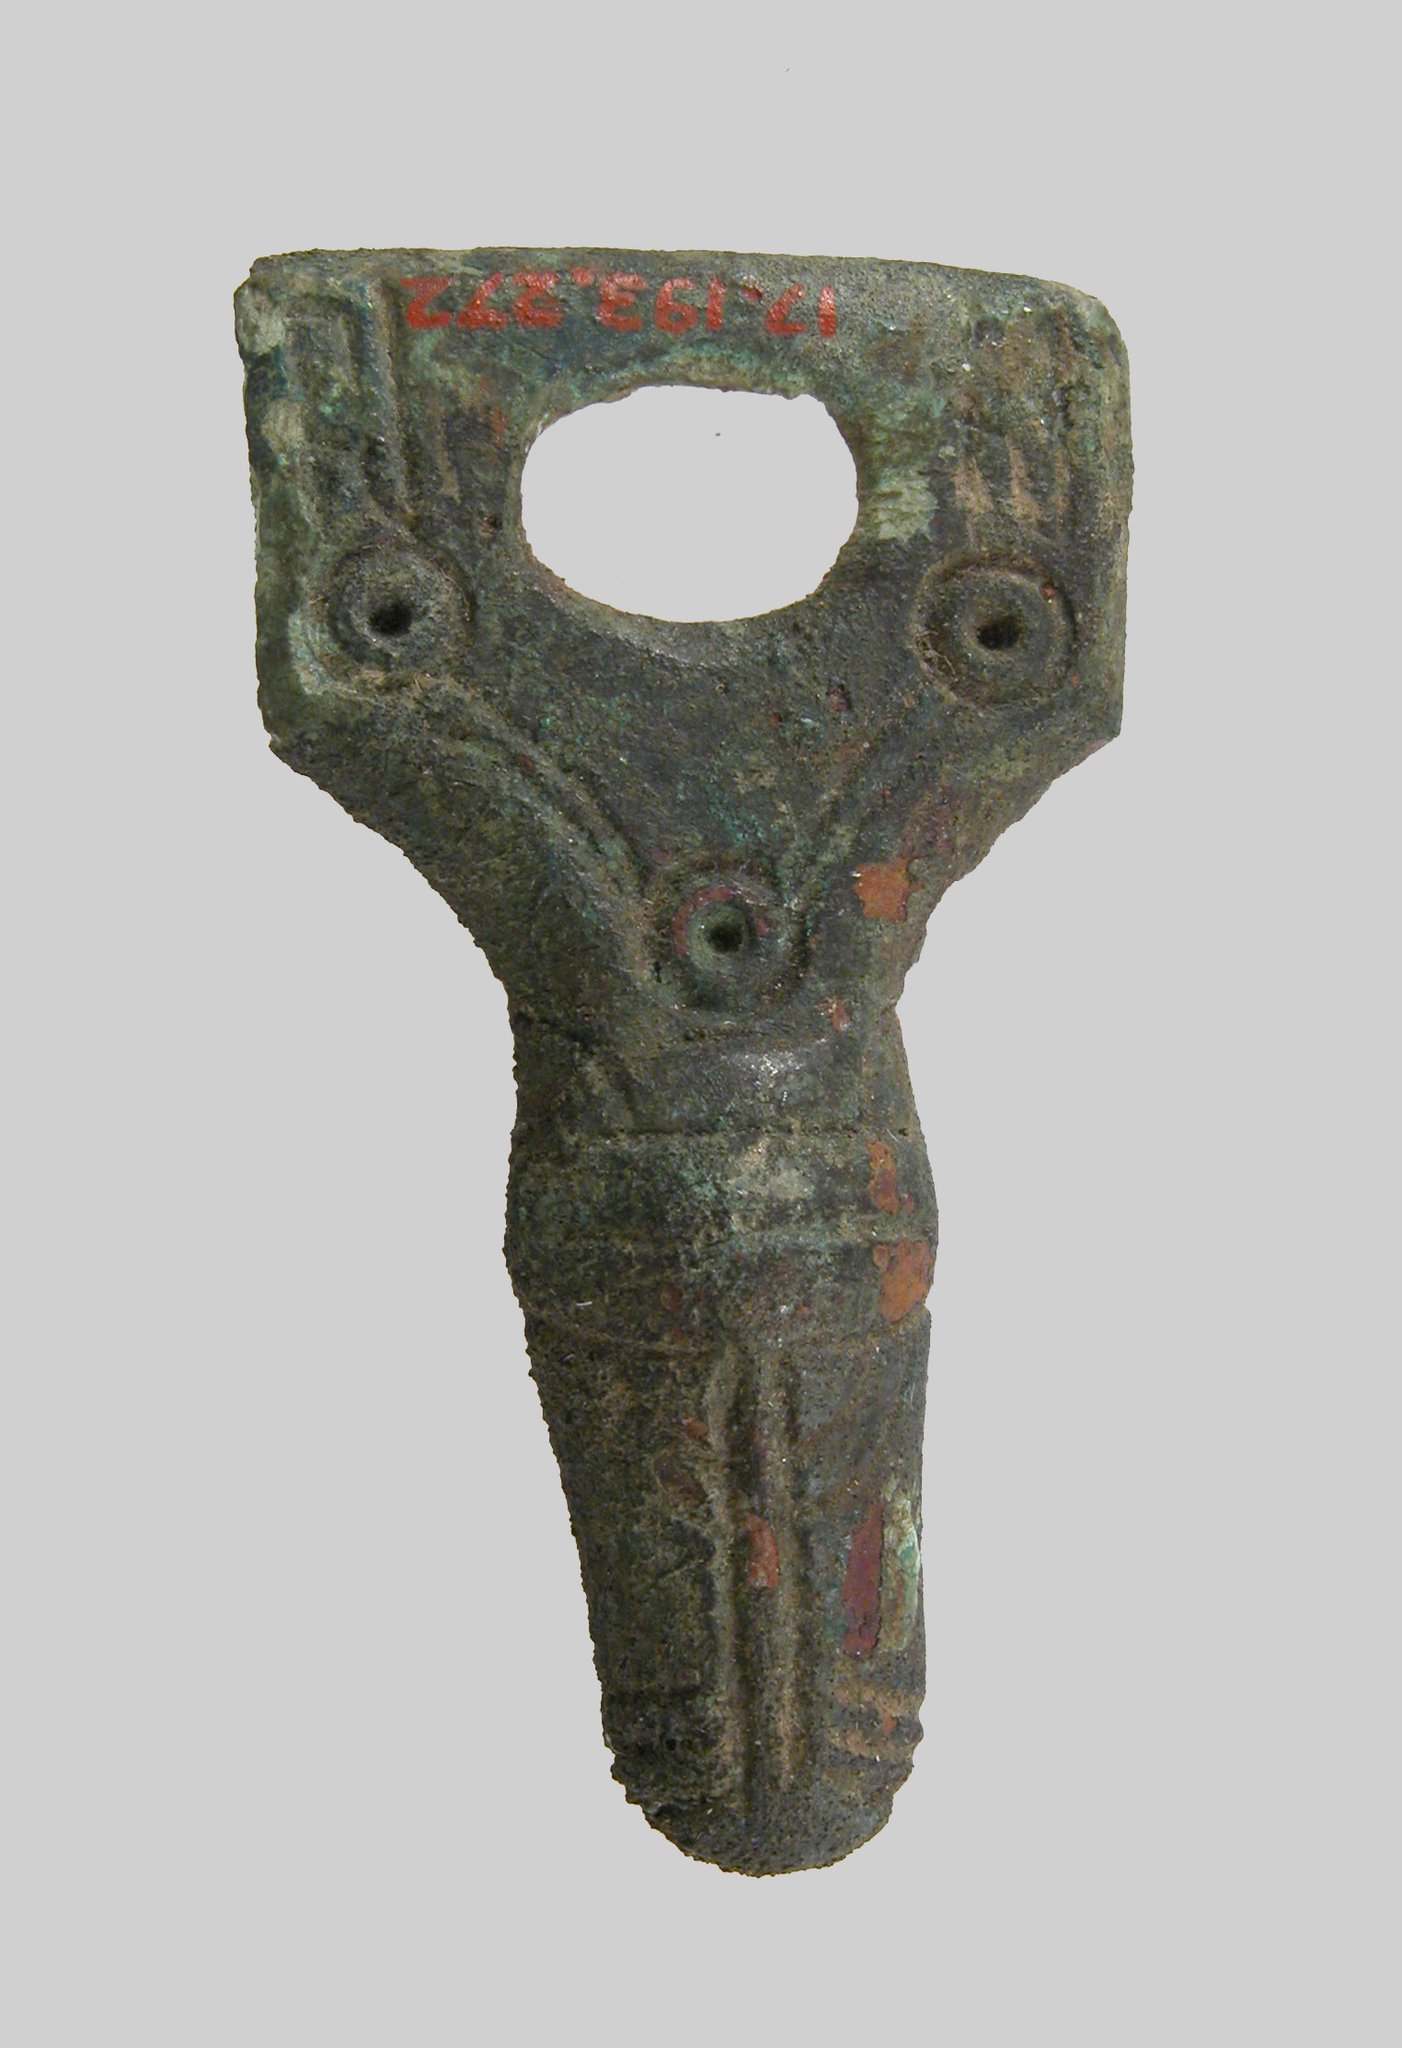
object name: belt ornament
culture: frankish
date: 534-566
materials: copper alloy